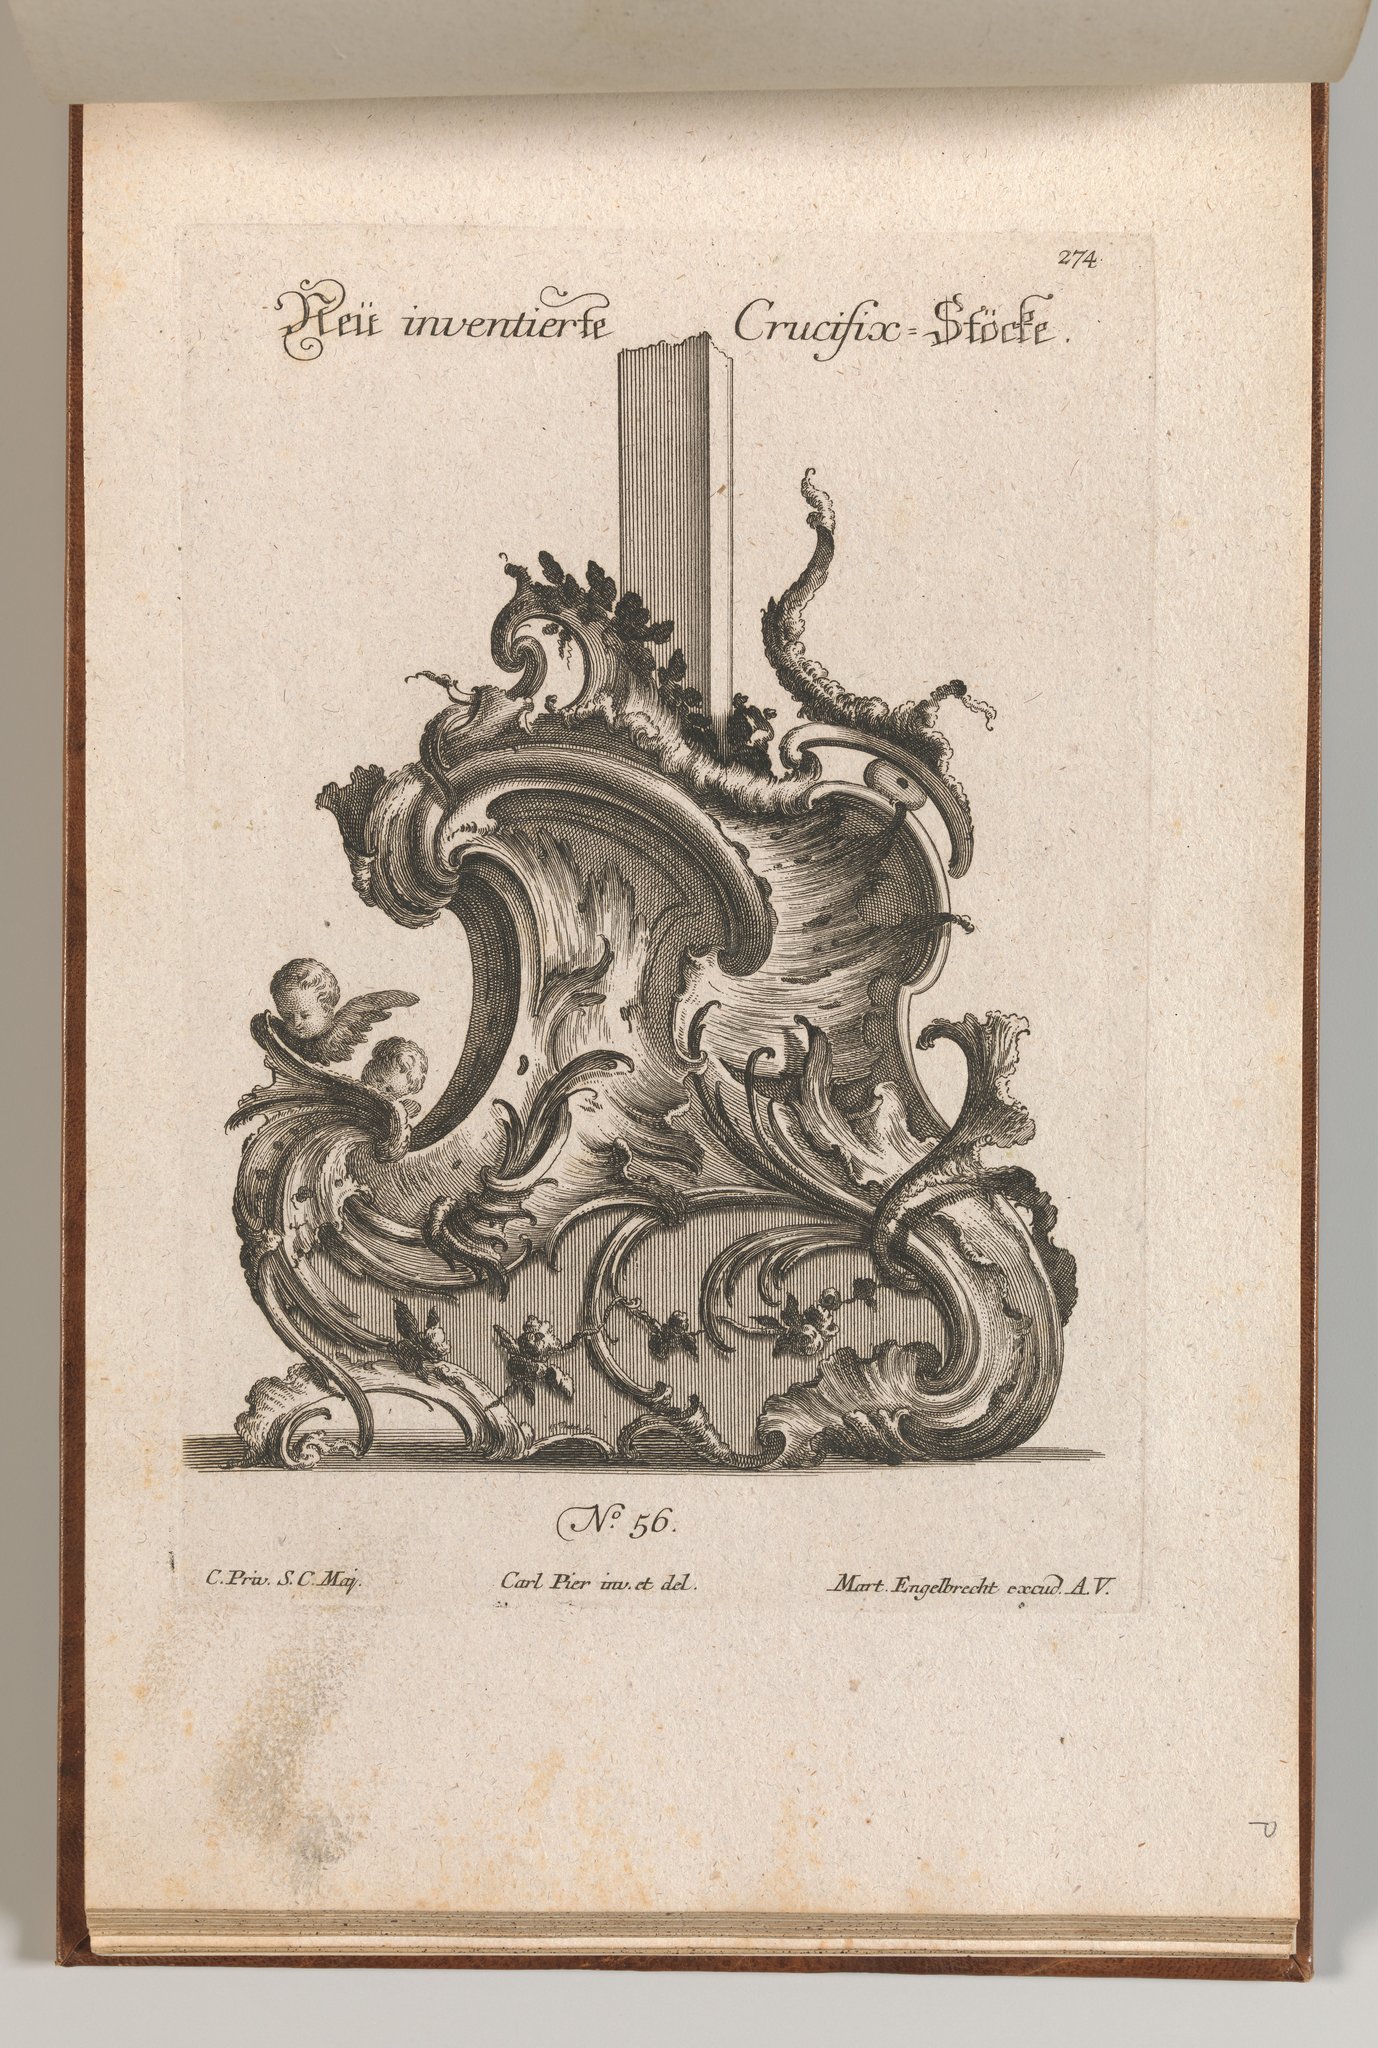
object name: album print ornament architecture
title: Design for the Base of a Crucifix, Plate 1 from: 'Neü inventierte Crucifix= Stöcke'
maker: jacob gottlieb thelot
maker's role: engraver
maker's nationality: central european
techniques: etching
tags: ornament